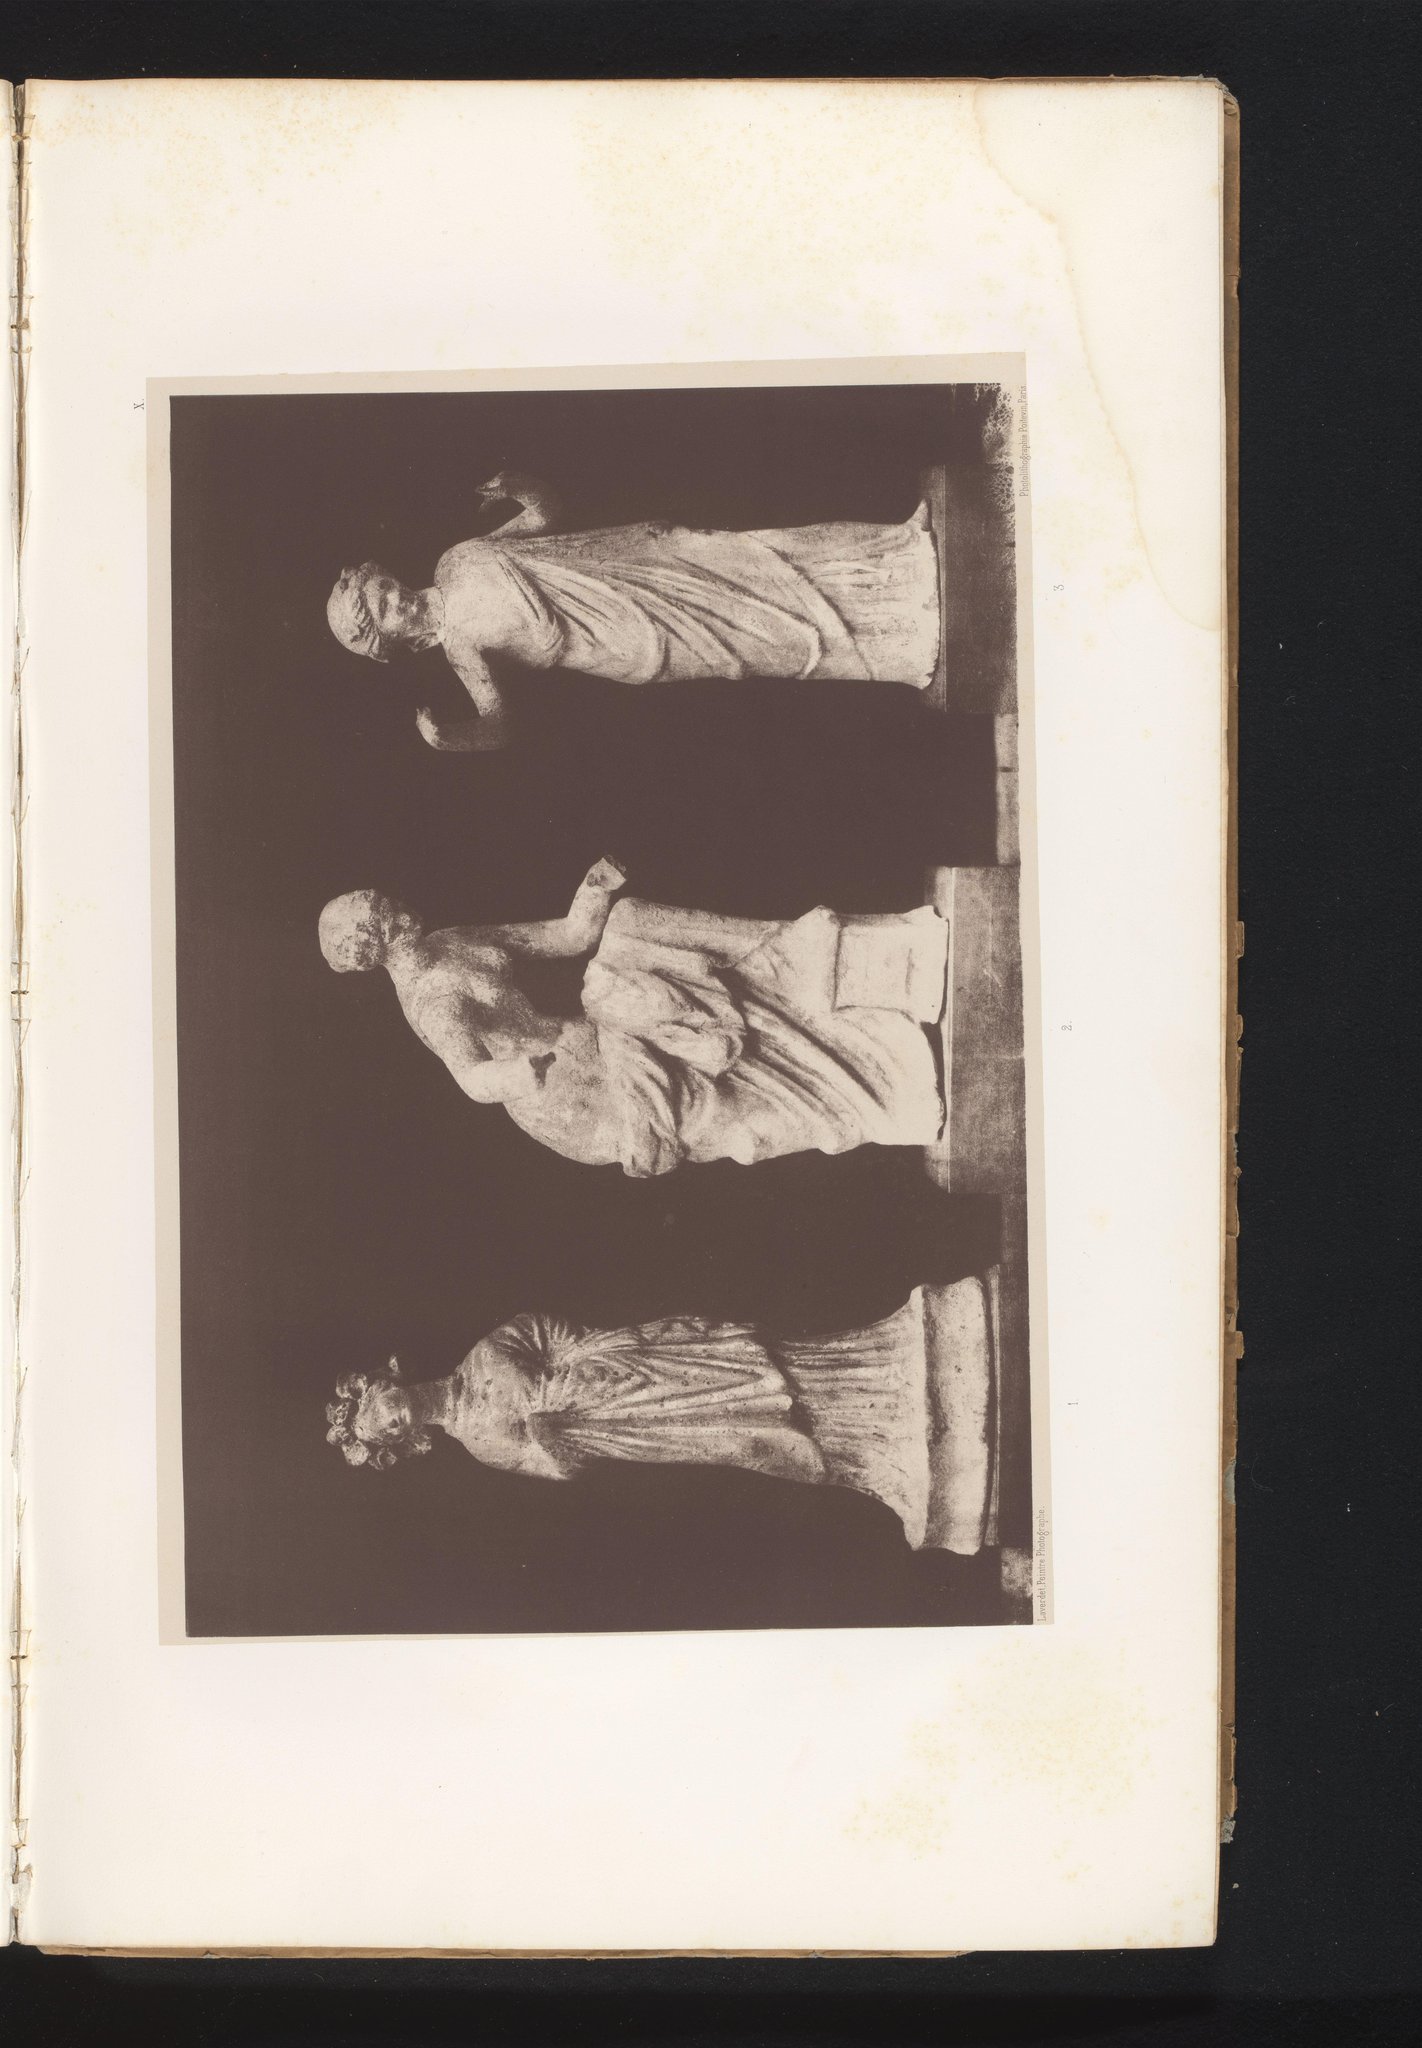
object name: photomechanical print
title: Drie terracotta sculpturen van twee vrouwen en een priesteres van Bacchus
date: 1852-1857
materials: paper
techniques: photolithography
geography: paris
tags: adult woman, piece of sculpture, reproduction of a piece of sculpture (+ clay, sand, etc. ~ arts), maenad(s), female bacchant(es)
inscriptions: number: ‘X.’, number: ‘1. 2. 3.’